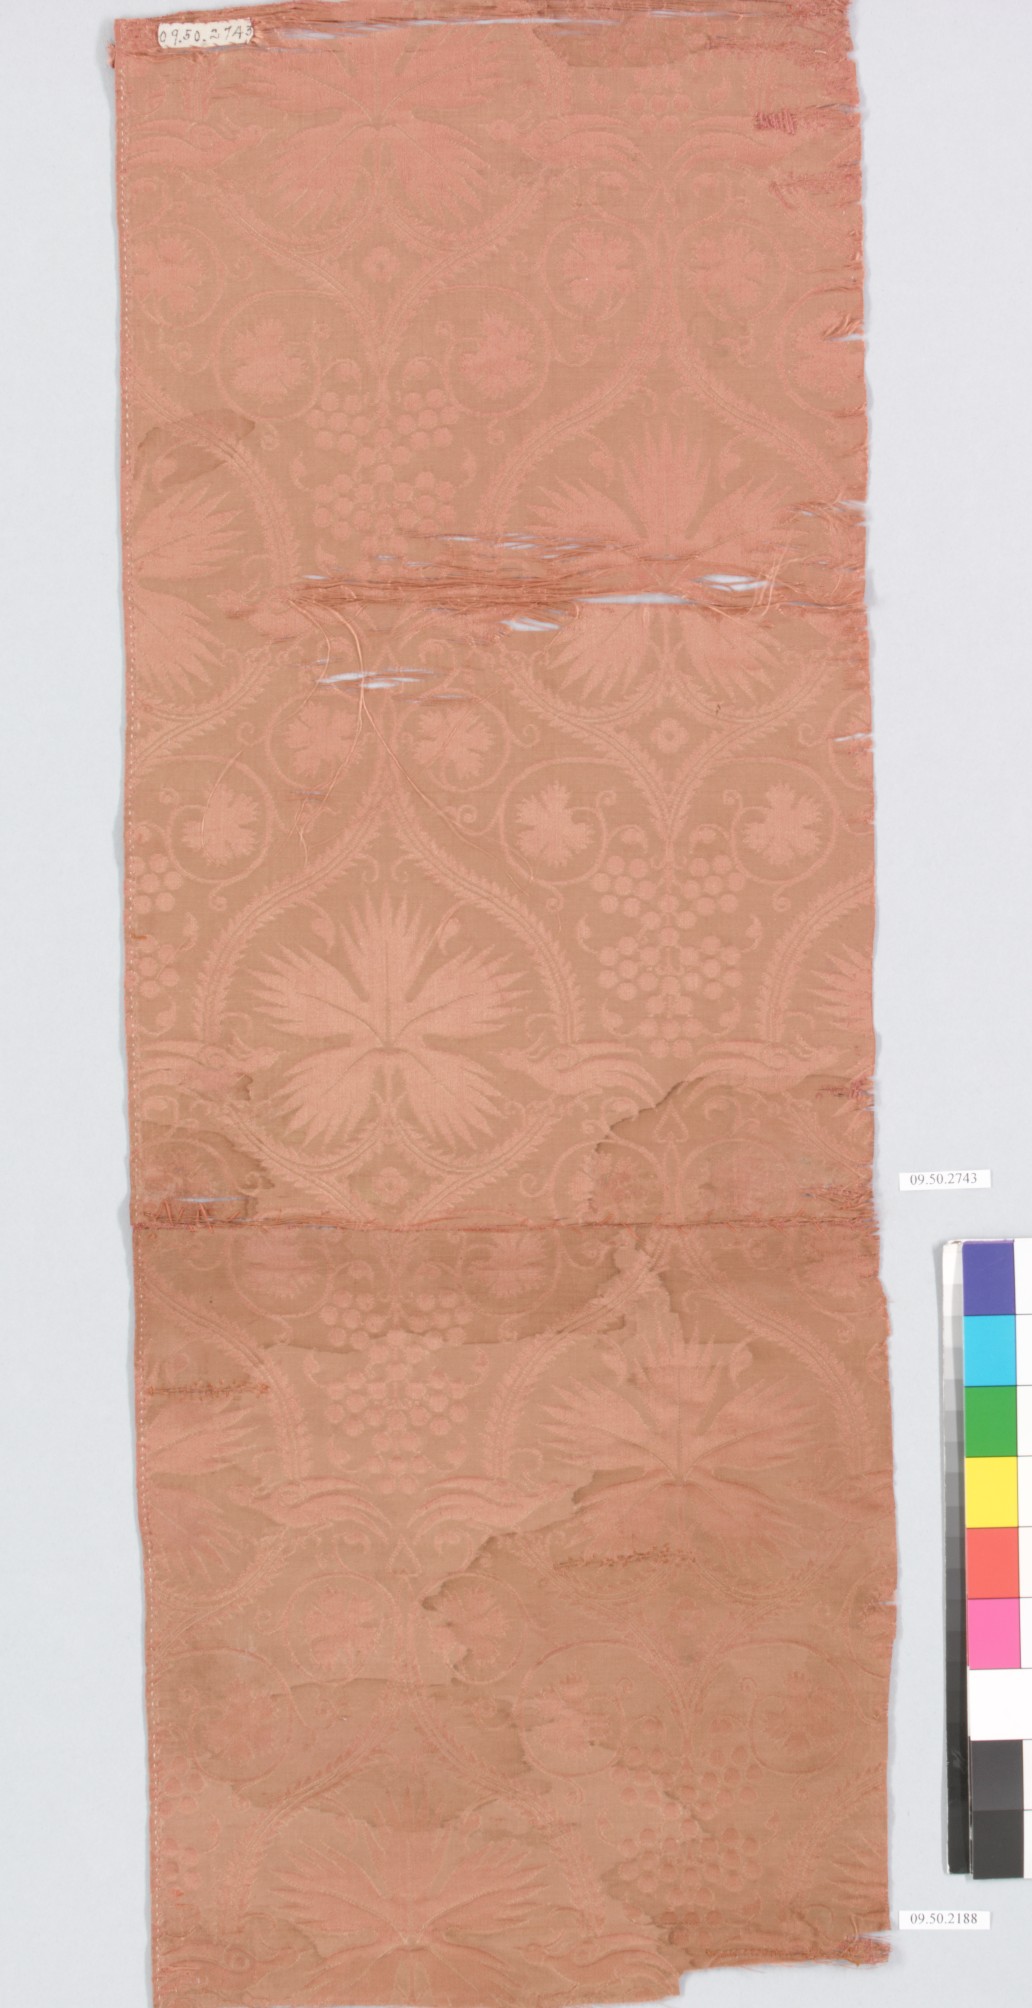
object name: fragment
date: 1801-1900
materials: silk